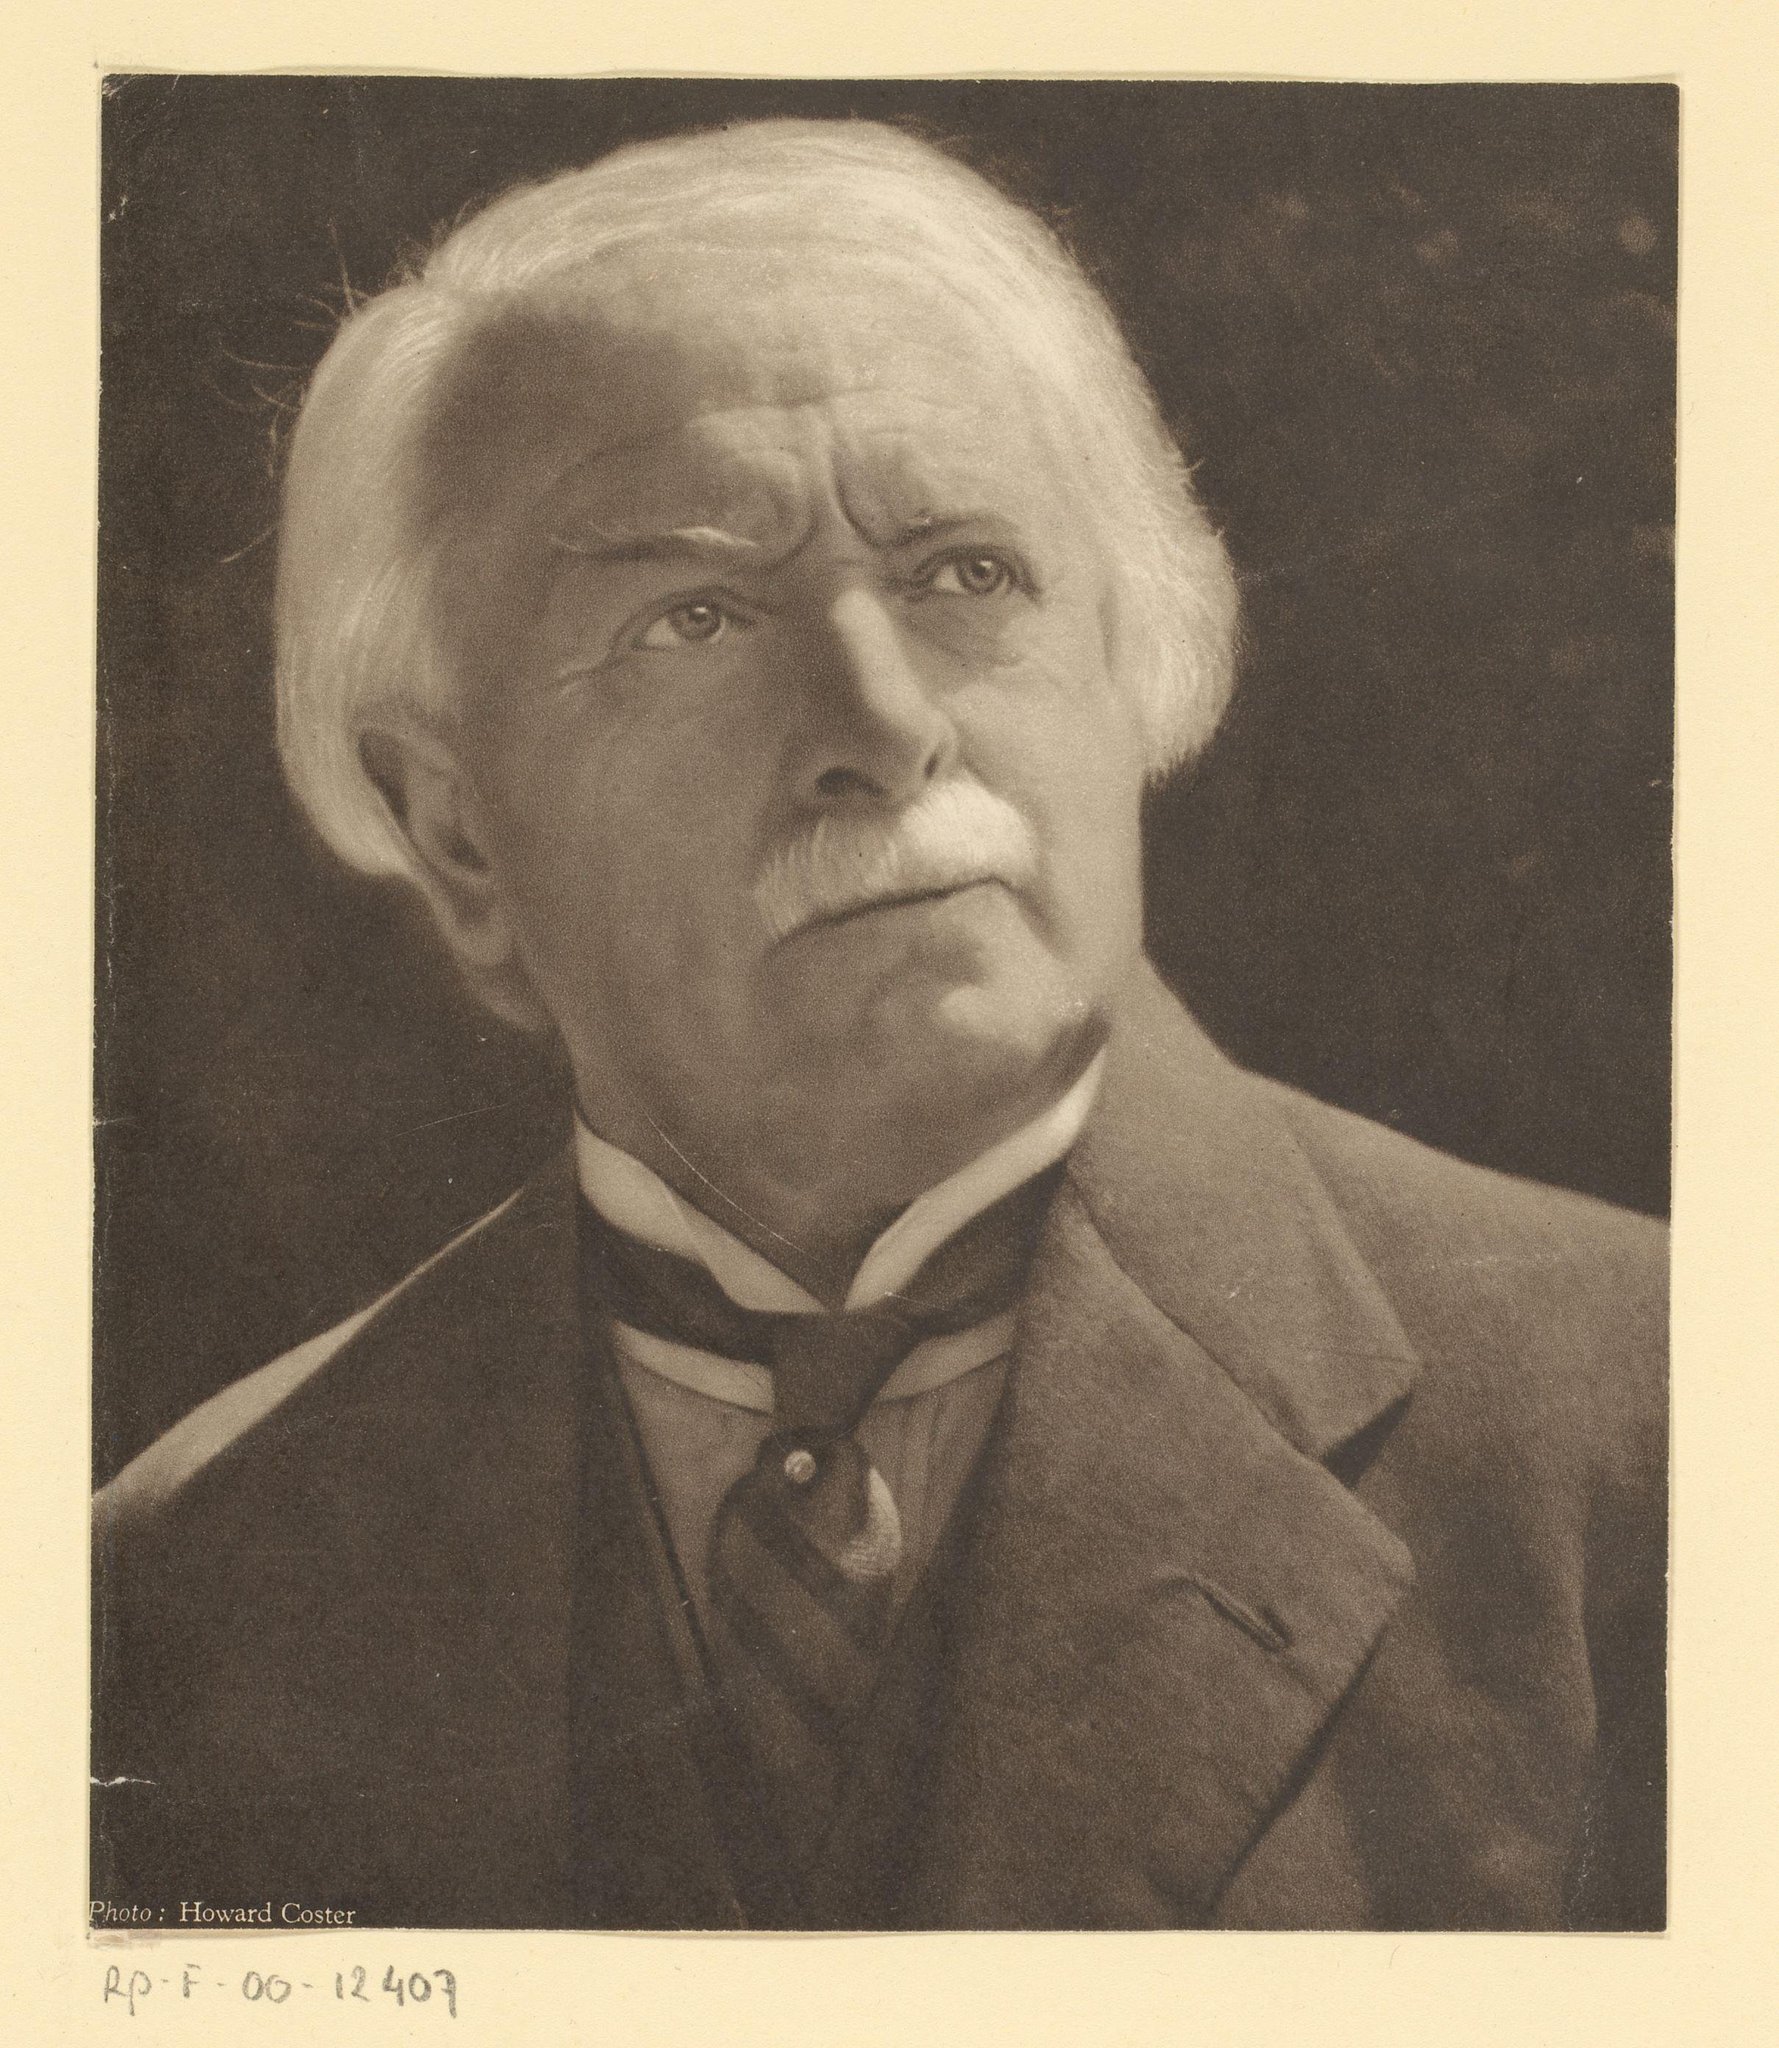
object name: photograph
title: Portret van David Lloyd George, premier van het Verenigd Koninkrijk tussen 1916 en 1922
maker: howard coster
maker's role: fotograaf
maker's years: 1885-1959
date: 1916-1945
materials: paper, cardboard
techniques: gelatin silver print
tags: historical persons, politician, e.g. party leader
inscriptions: inscription: ‘Lloyd George’